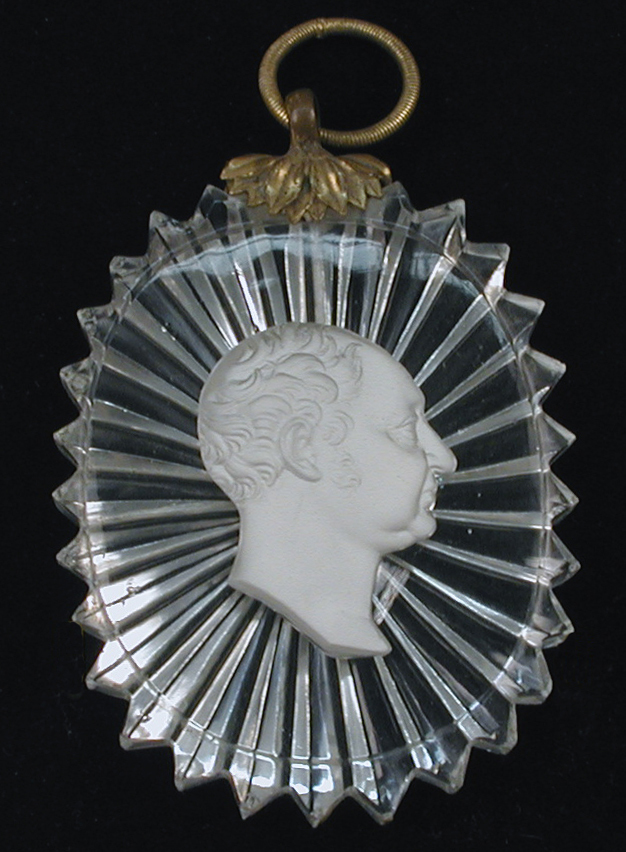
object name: medallion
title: Maximilian I Joseph of Bavaria (1756–1825, r. 1806–25)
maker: désprez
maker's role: maker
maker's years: 1773-1815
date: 1815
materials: biscuit, gilt bronze, glass, porcelain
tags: men,profiles